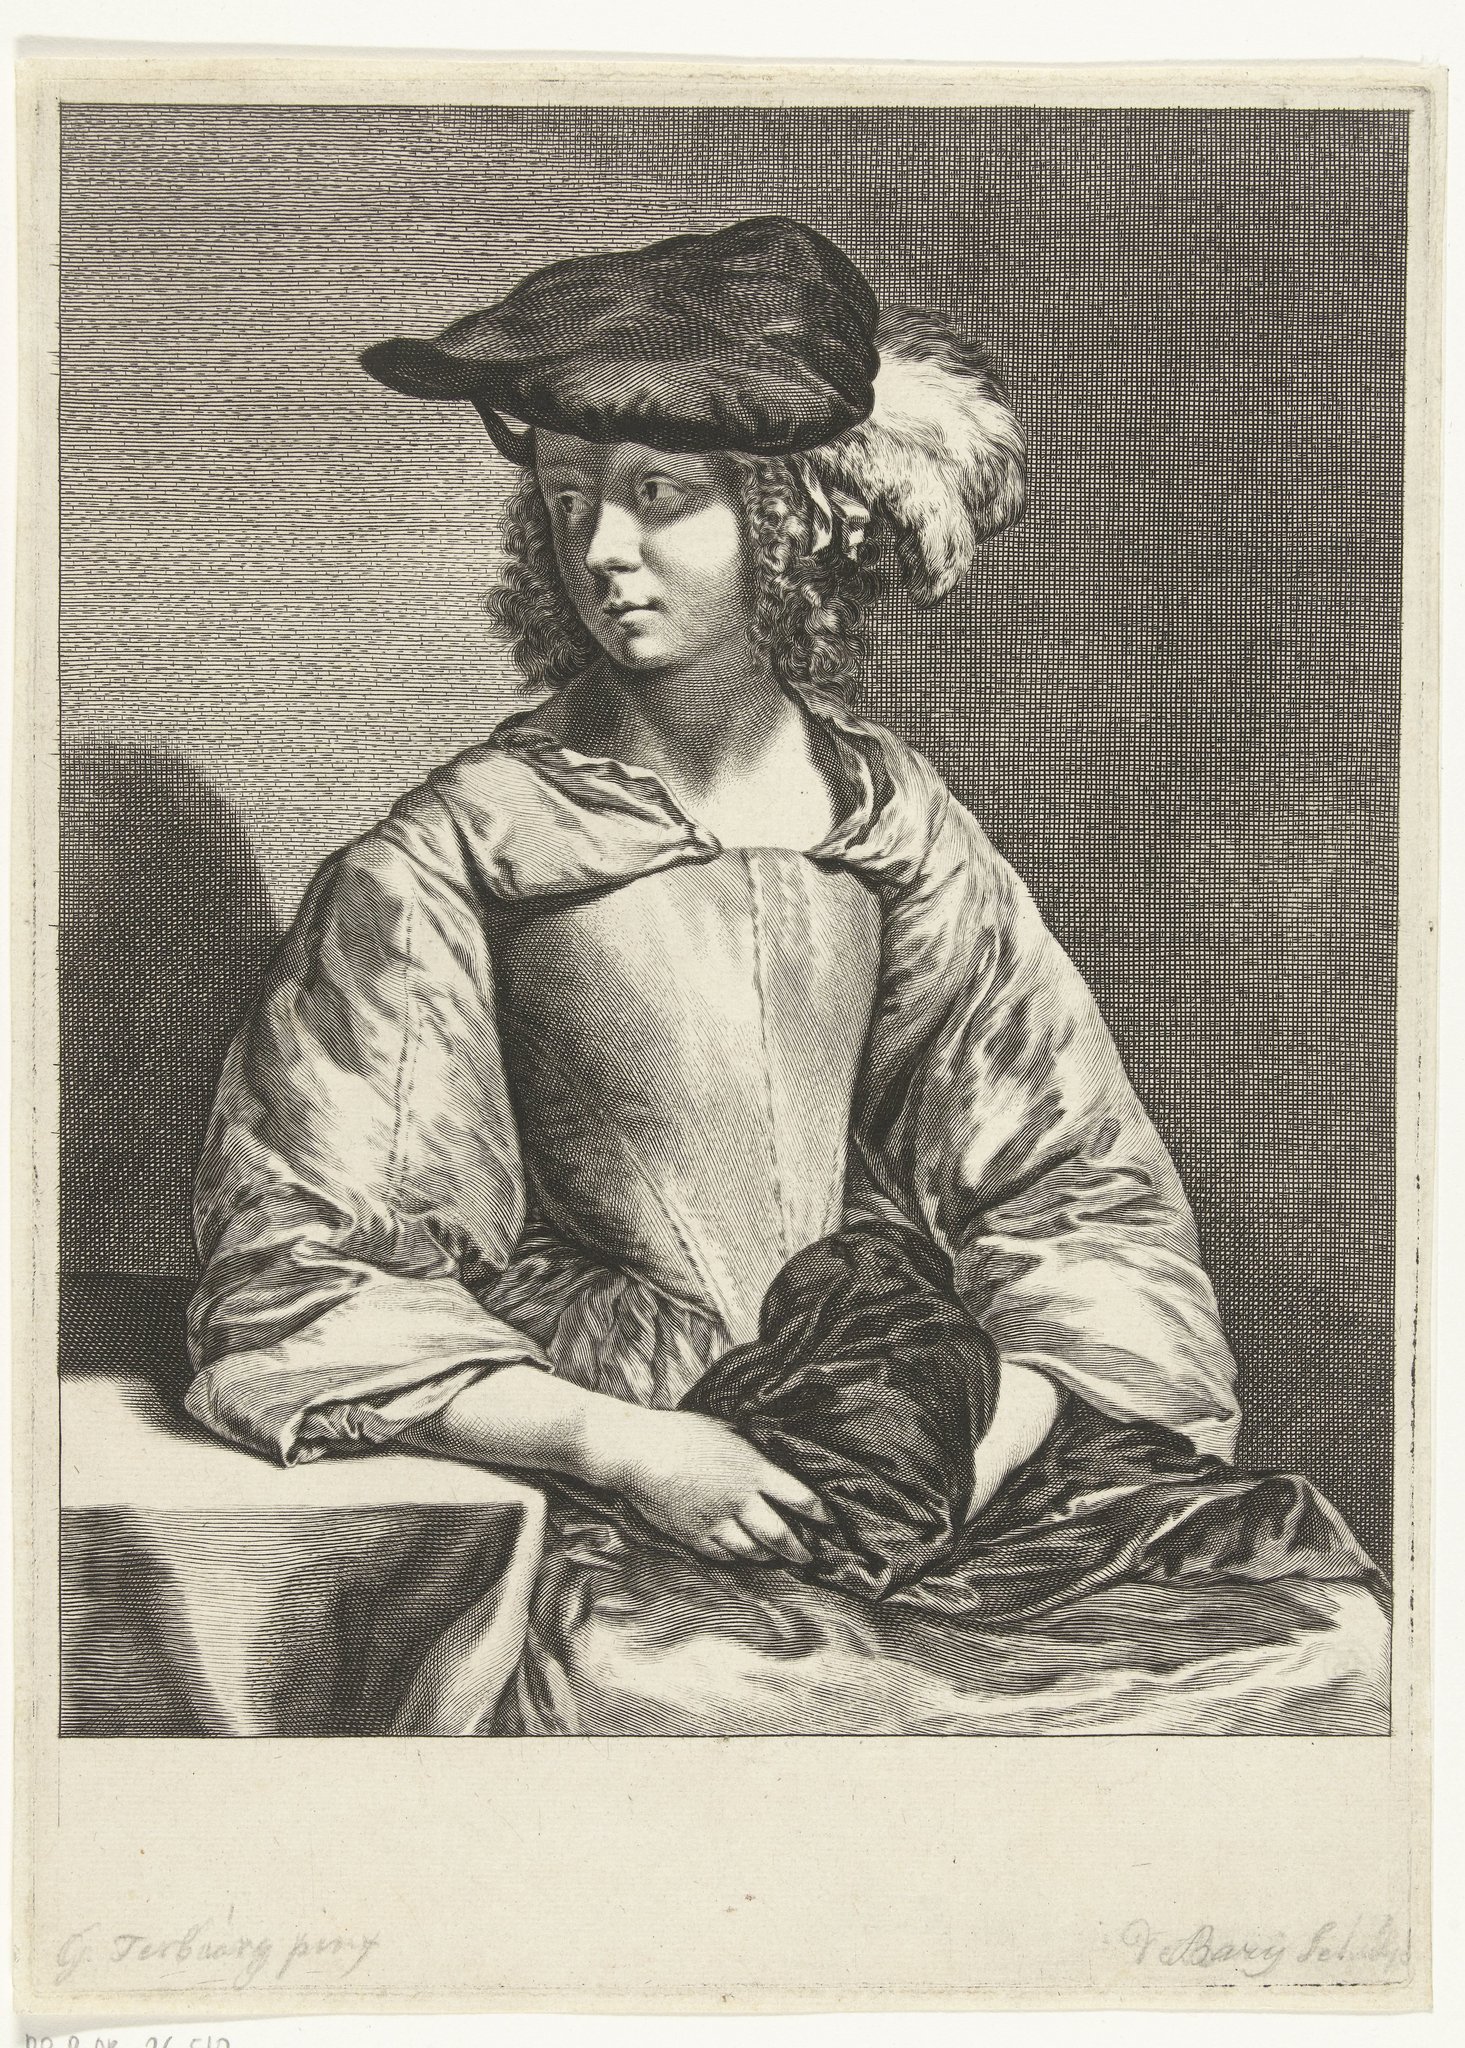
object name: print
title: Jonge vrouw met baret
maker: hendrik bary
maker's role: draughtsman, print maker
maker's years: 1640-1707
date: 1657-1707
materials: paper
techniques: engraving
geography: netherlands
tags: anonymous historical person portrayed alone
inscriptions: collector's mark: Lugt 2228, collector's mark: Lugt 2165, collector's mark: Lugt 573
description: Portret van een jonge vrouw met baret, zittend aan een tafel.